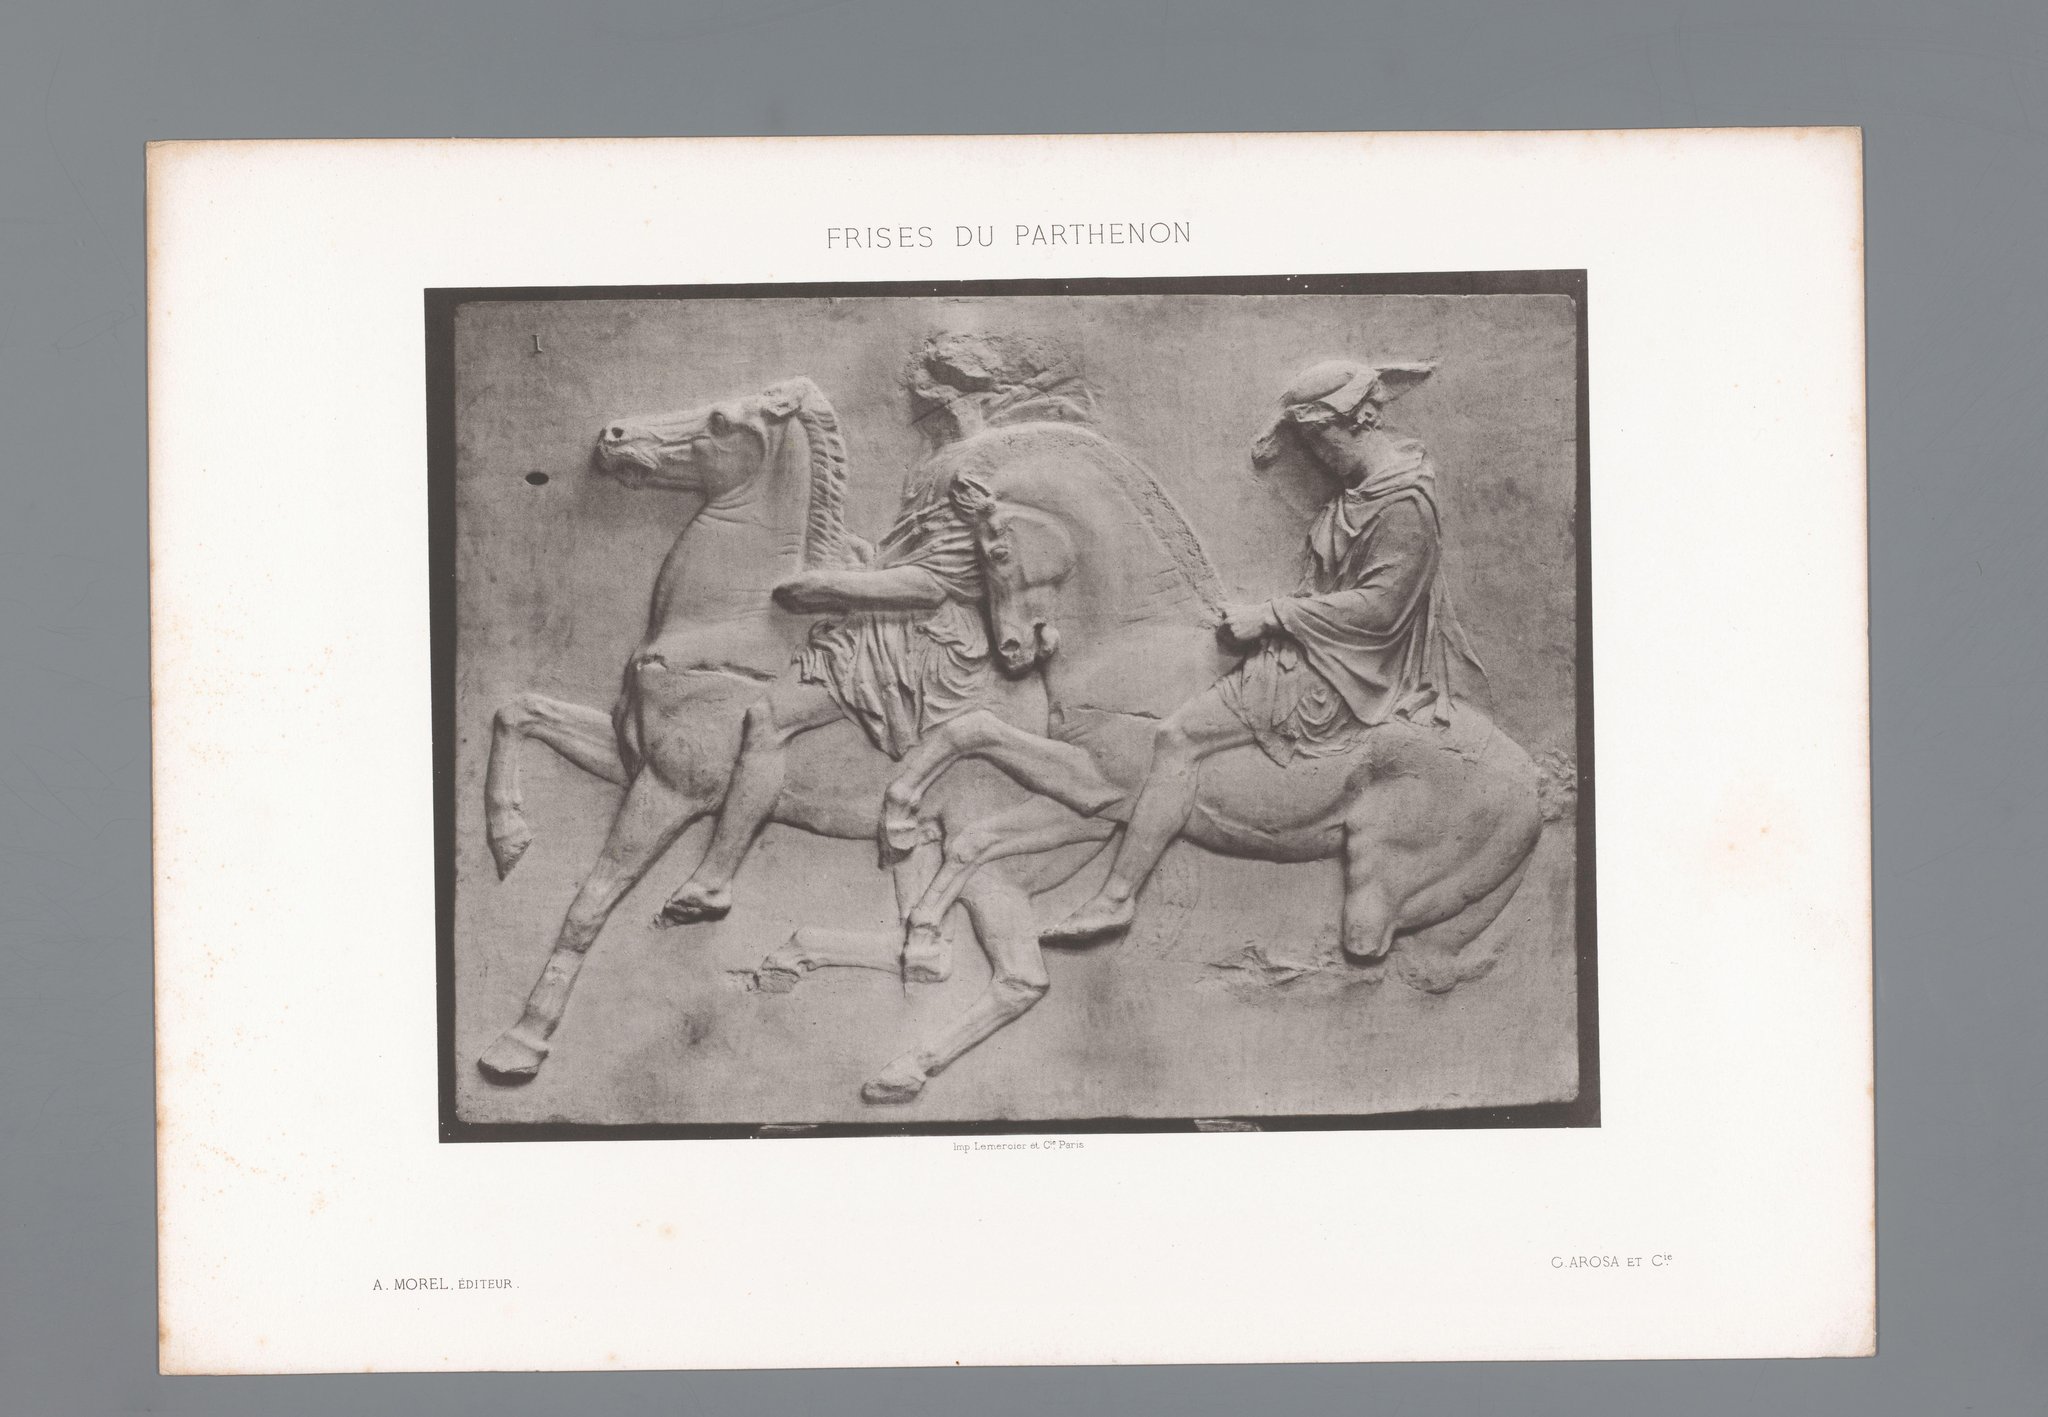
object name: photomechanical print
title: Frises du Parthenon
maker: a. morel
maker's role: publisher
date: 1863-1868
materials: paper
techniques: photograph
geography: paris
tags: riding a horse, ass, or mule; rider, horseman (+ two persons ~ traffic and transport), mouldings ~ architecture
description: Deze prent maakt deel uit van een omslag met 22 prenten en 3 tekstbladen.